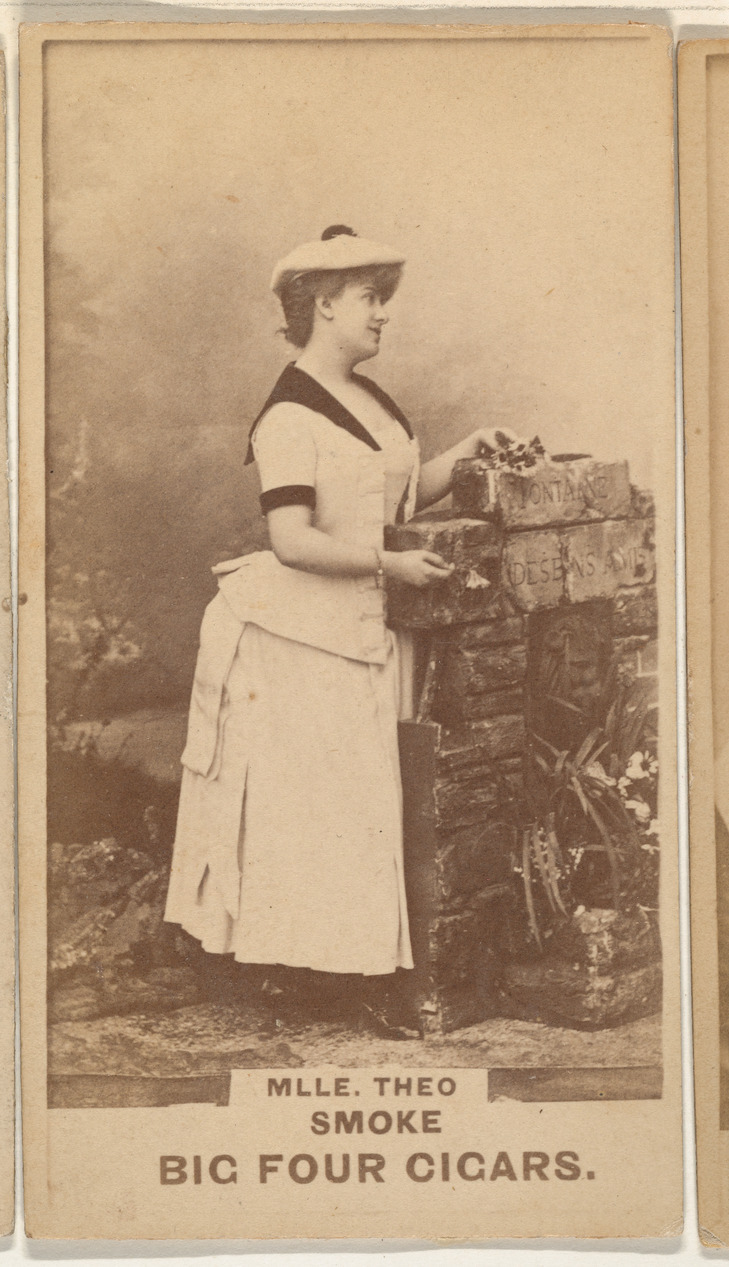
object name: photograph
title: Mlle. Theo, from the Actresses series (N669) promoting Big Four Cigars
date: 1888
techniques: albumen silver print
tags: portraits,women,actresses